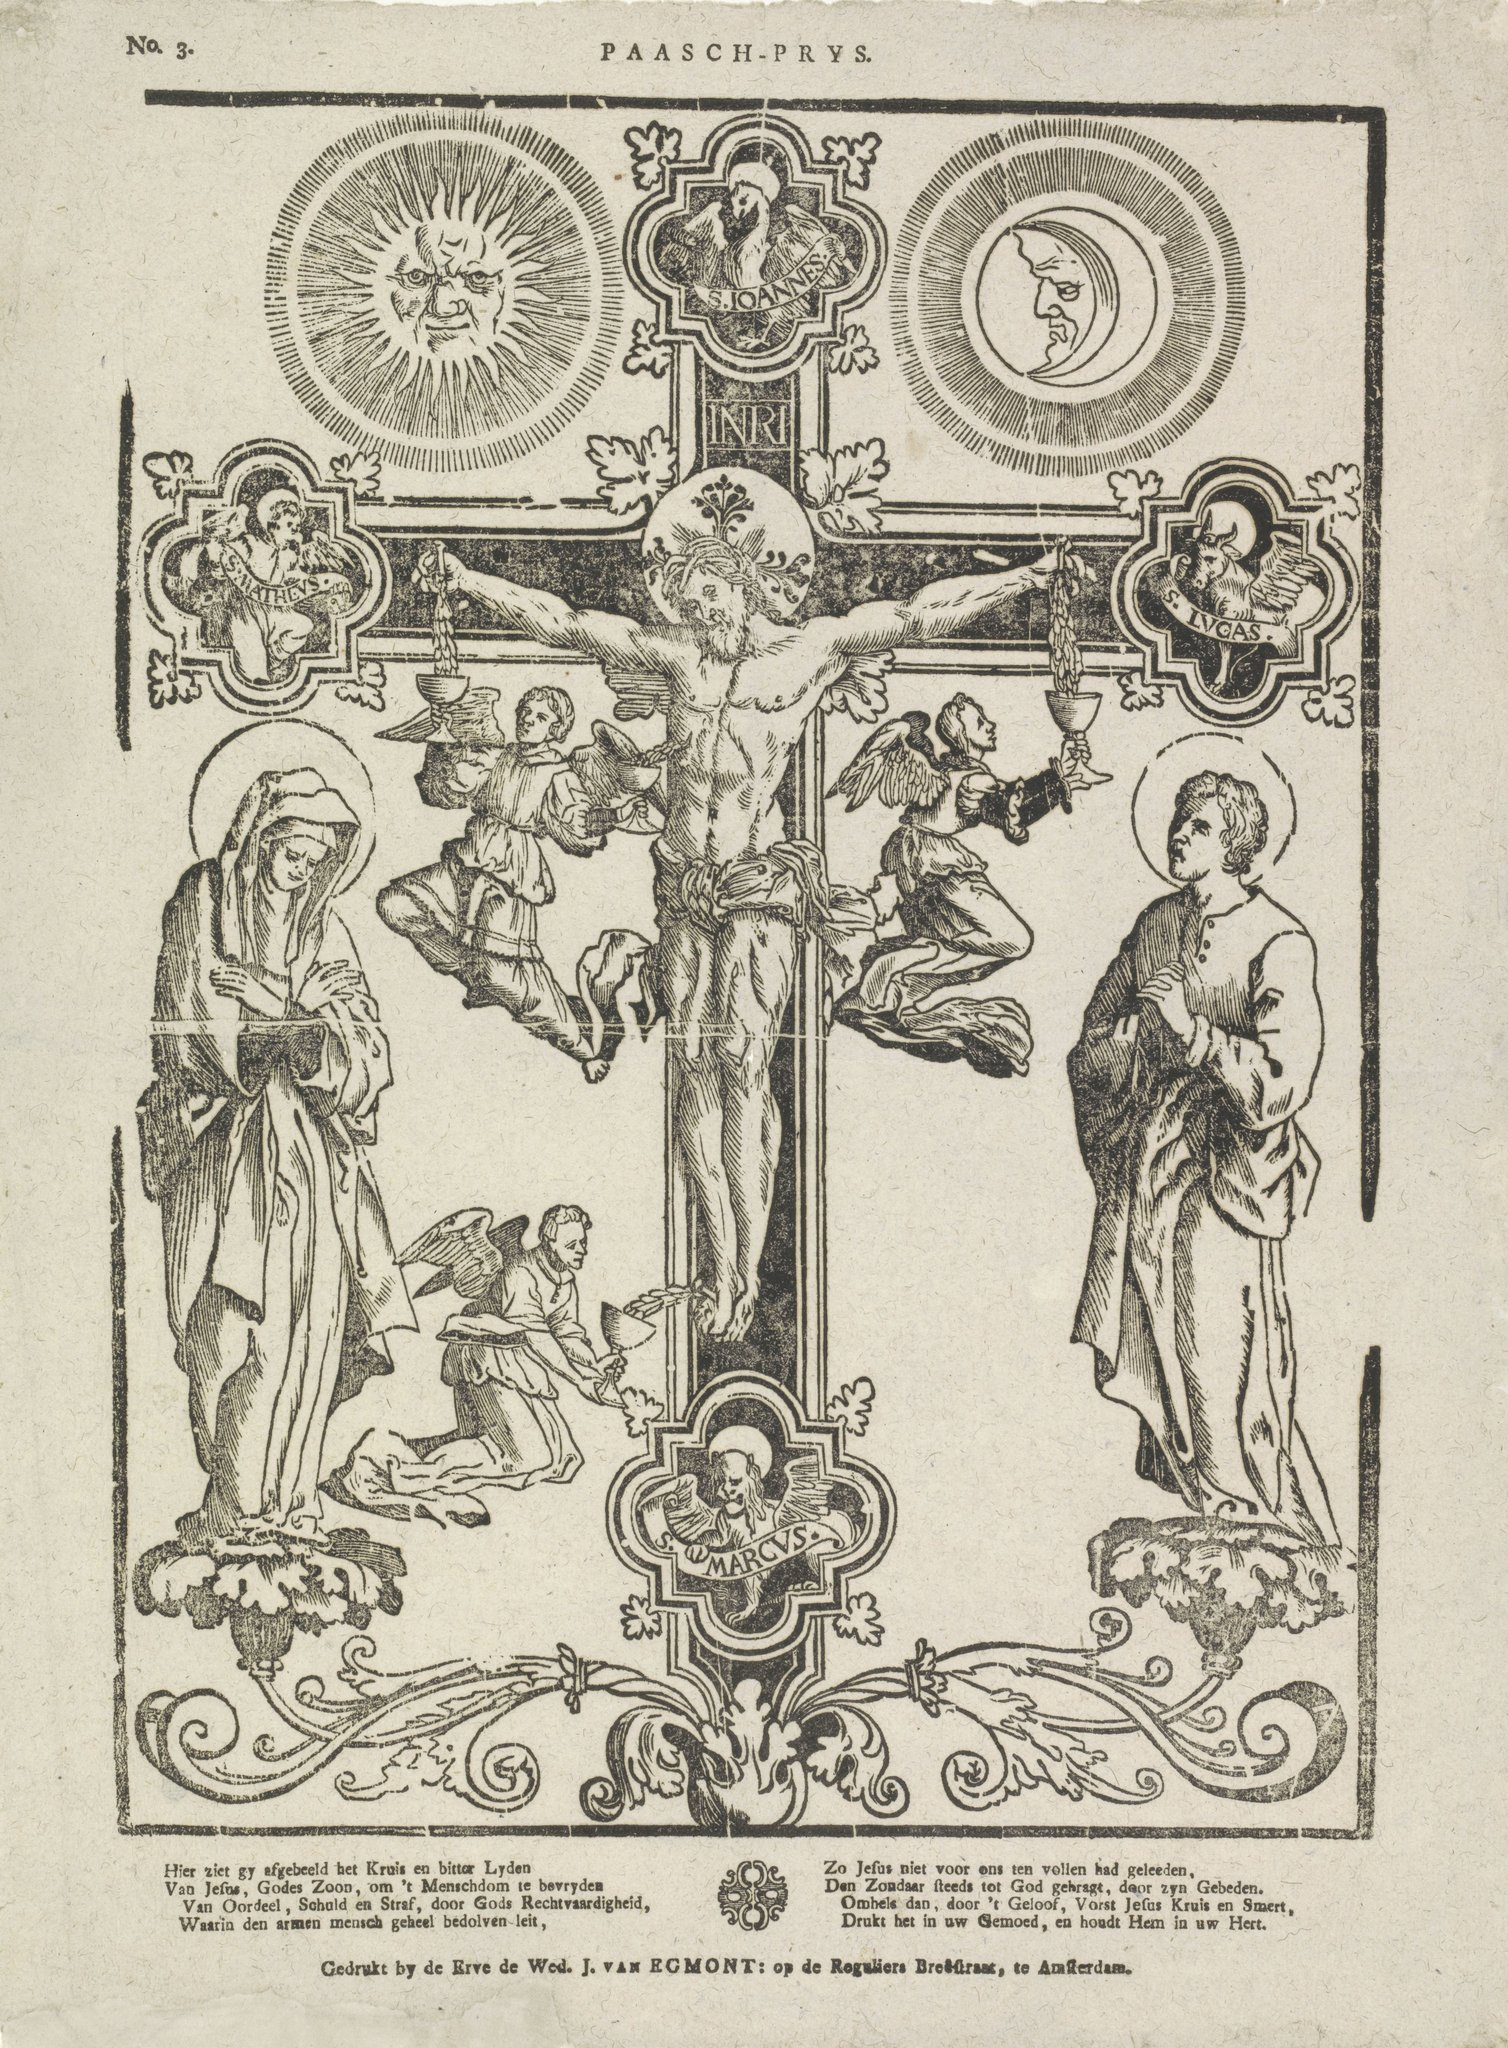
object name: print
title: Paasch-prys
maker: Anonymous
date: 1761-1804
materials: paper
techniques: letterpress printing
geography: netherlands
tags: angel(s) catching christ's blood in cup(s), sun and moon in the sky at either side of the cross of christ, crucified christ with mary and john on either side of the cross; holy rood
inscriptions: collector's mark: Lugt 2760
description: Christus aan het kruis, met aan weerszijden engelen die zijn bloed opvangen in kelken. Links Maria, rechts Johannes in devotie. Het crucifix is gedecoreerd met de symbolen van de vier evangelisten. Linksboven de zon, rechtsboven de maan. Onder de afbeelding een achtregelig vers in twee kolommen. Genummerd linksboven: No. 3.